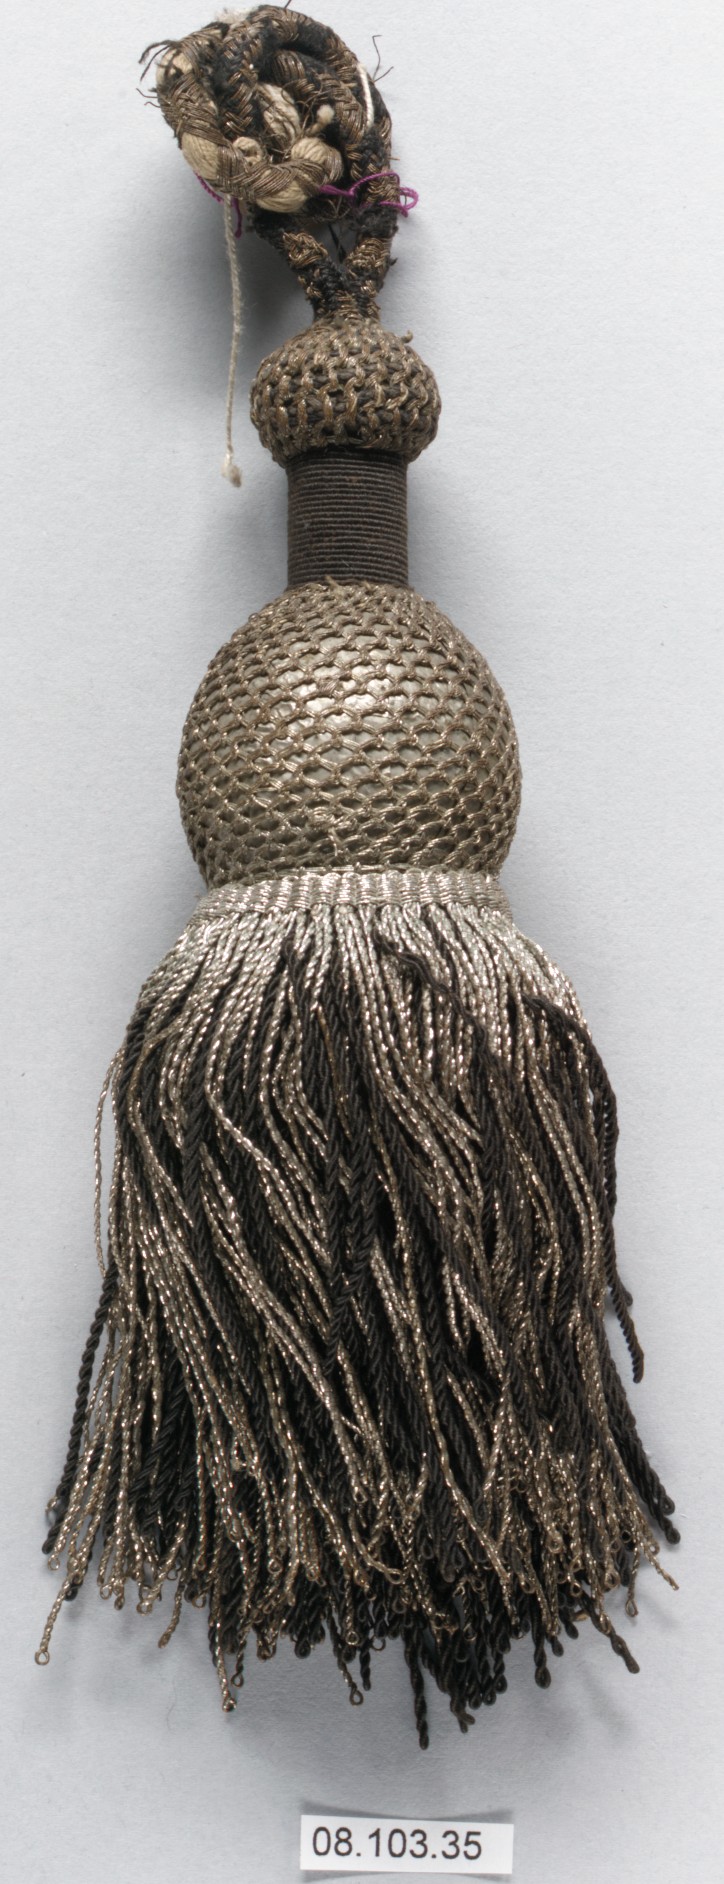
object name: tassel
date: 1801-1833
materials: metal thread, silk